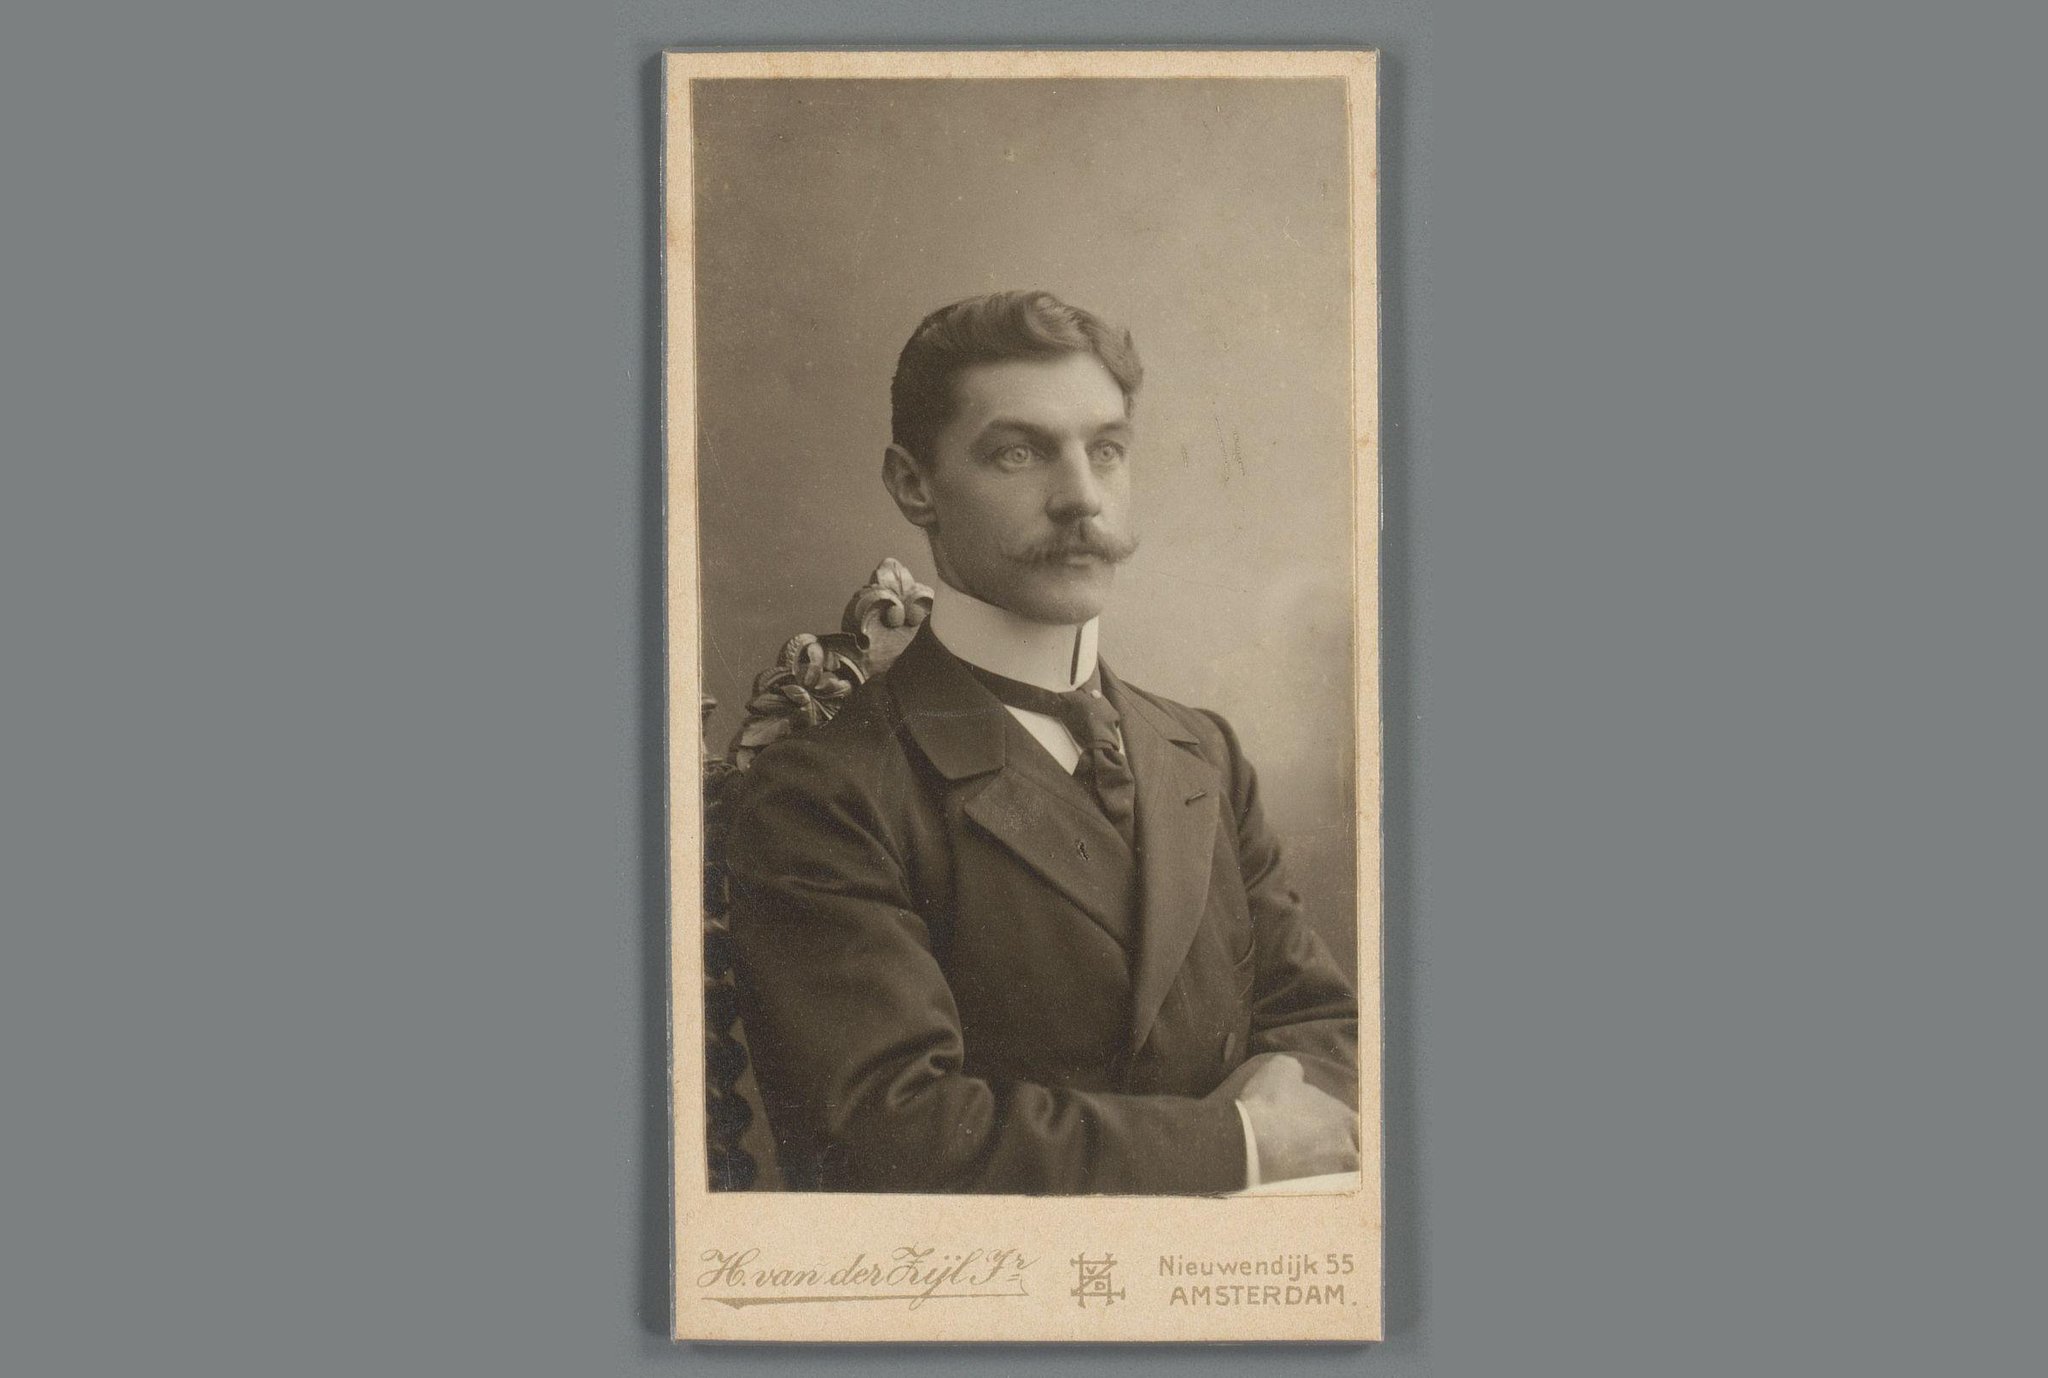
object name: photograph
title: Portret van een onbekende man met snor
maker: h. van der zijl jr.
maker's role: fotograaf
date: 1908-1912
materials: paper, cardboard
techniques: gelatin silver print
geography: amsterdam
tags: adult man, anonymous historical person portrayed, amsterdam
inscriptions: number: ‘71’, inscription: ‘H. van der Zijl Jr/ Nieuwendijk 55/ Amsterdam.’